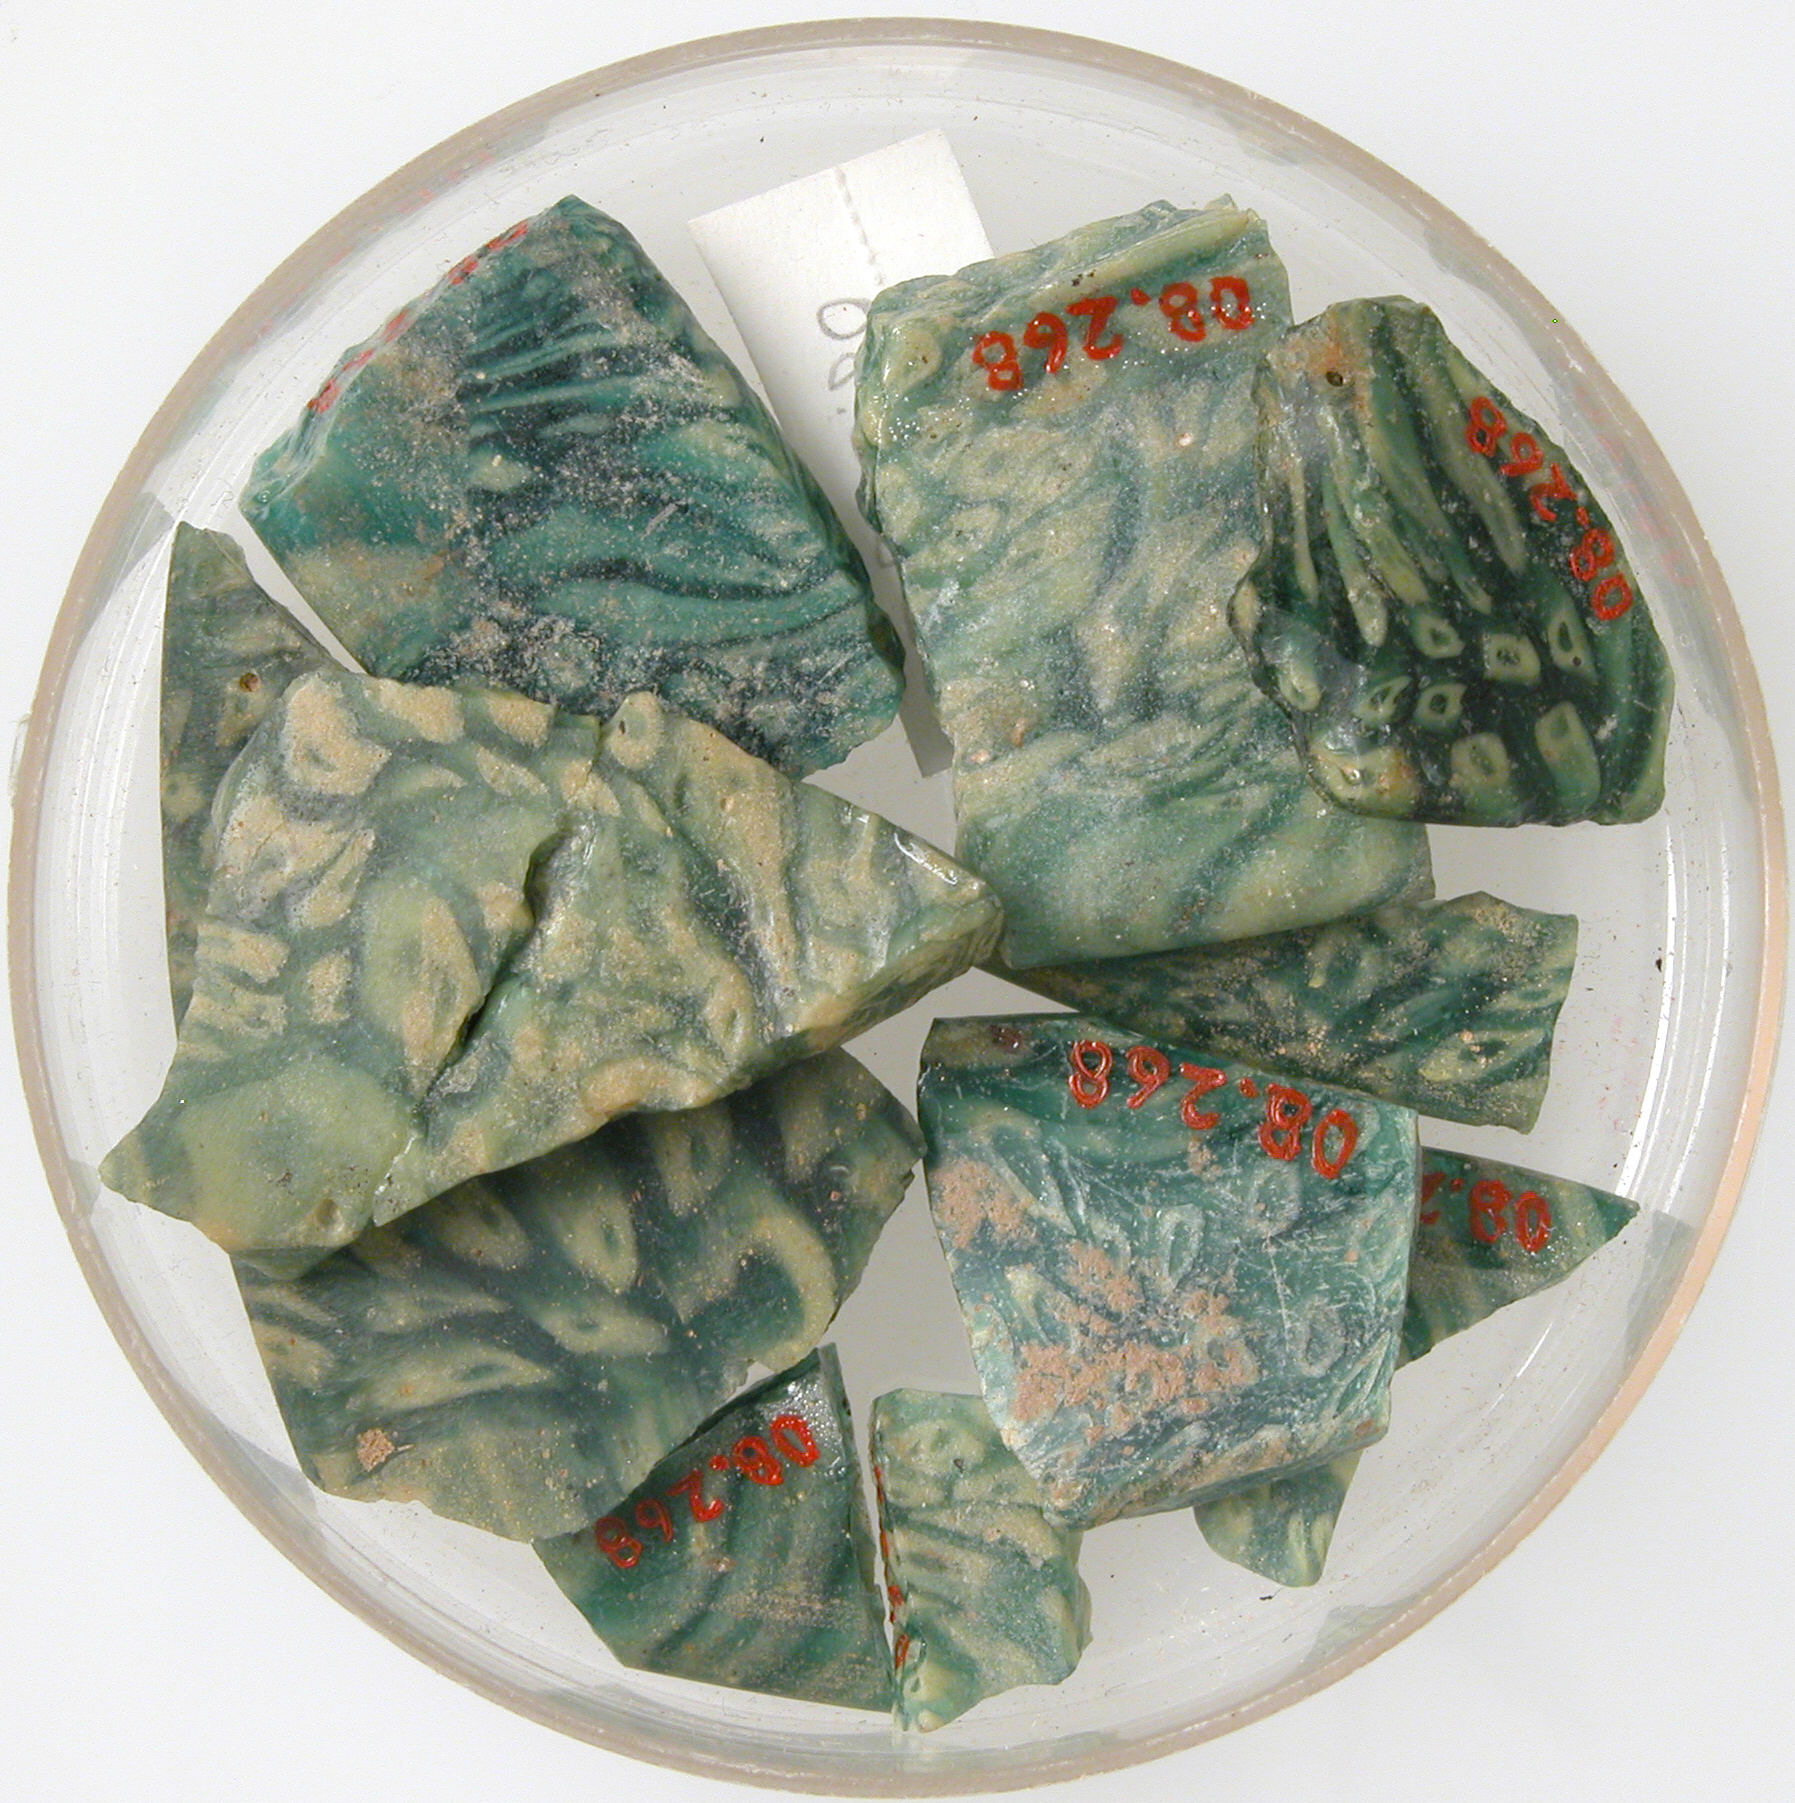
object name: fragment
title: Glass Fragments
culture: coptic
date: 301-433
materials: glass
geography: egypt